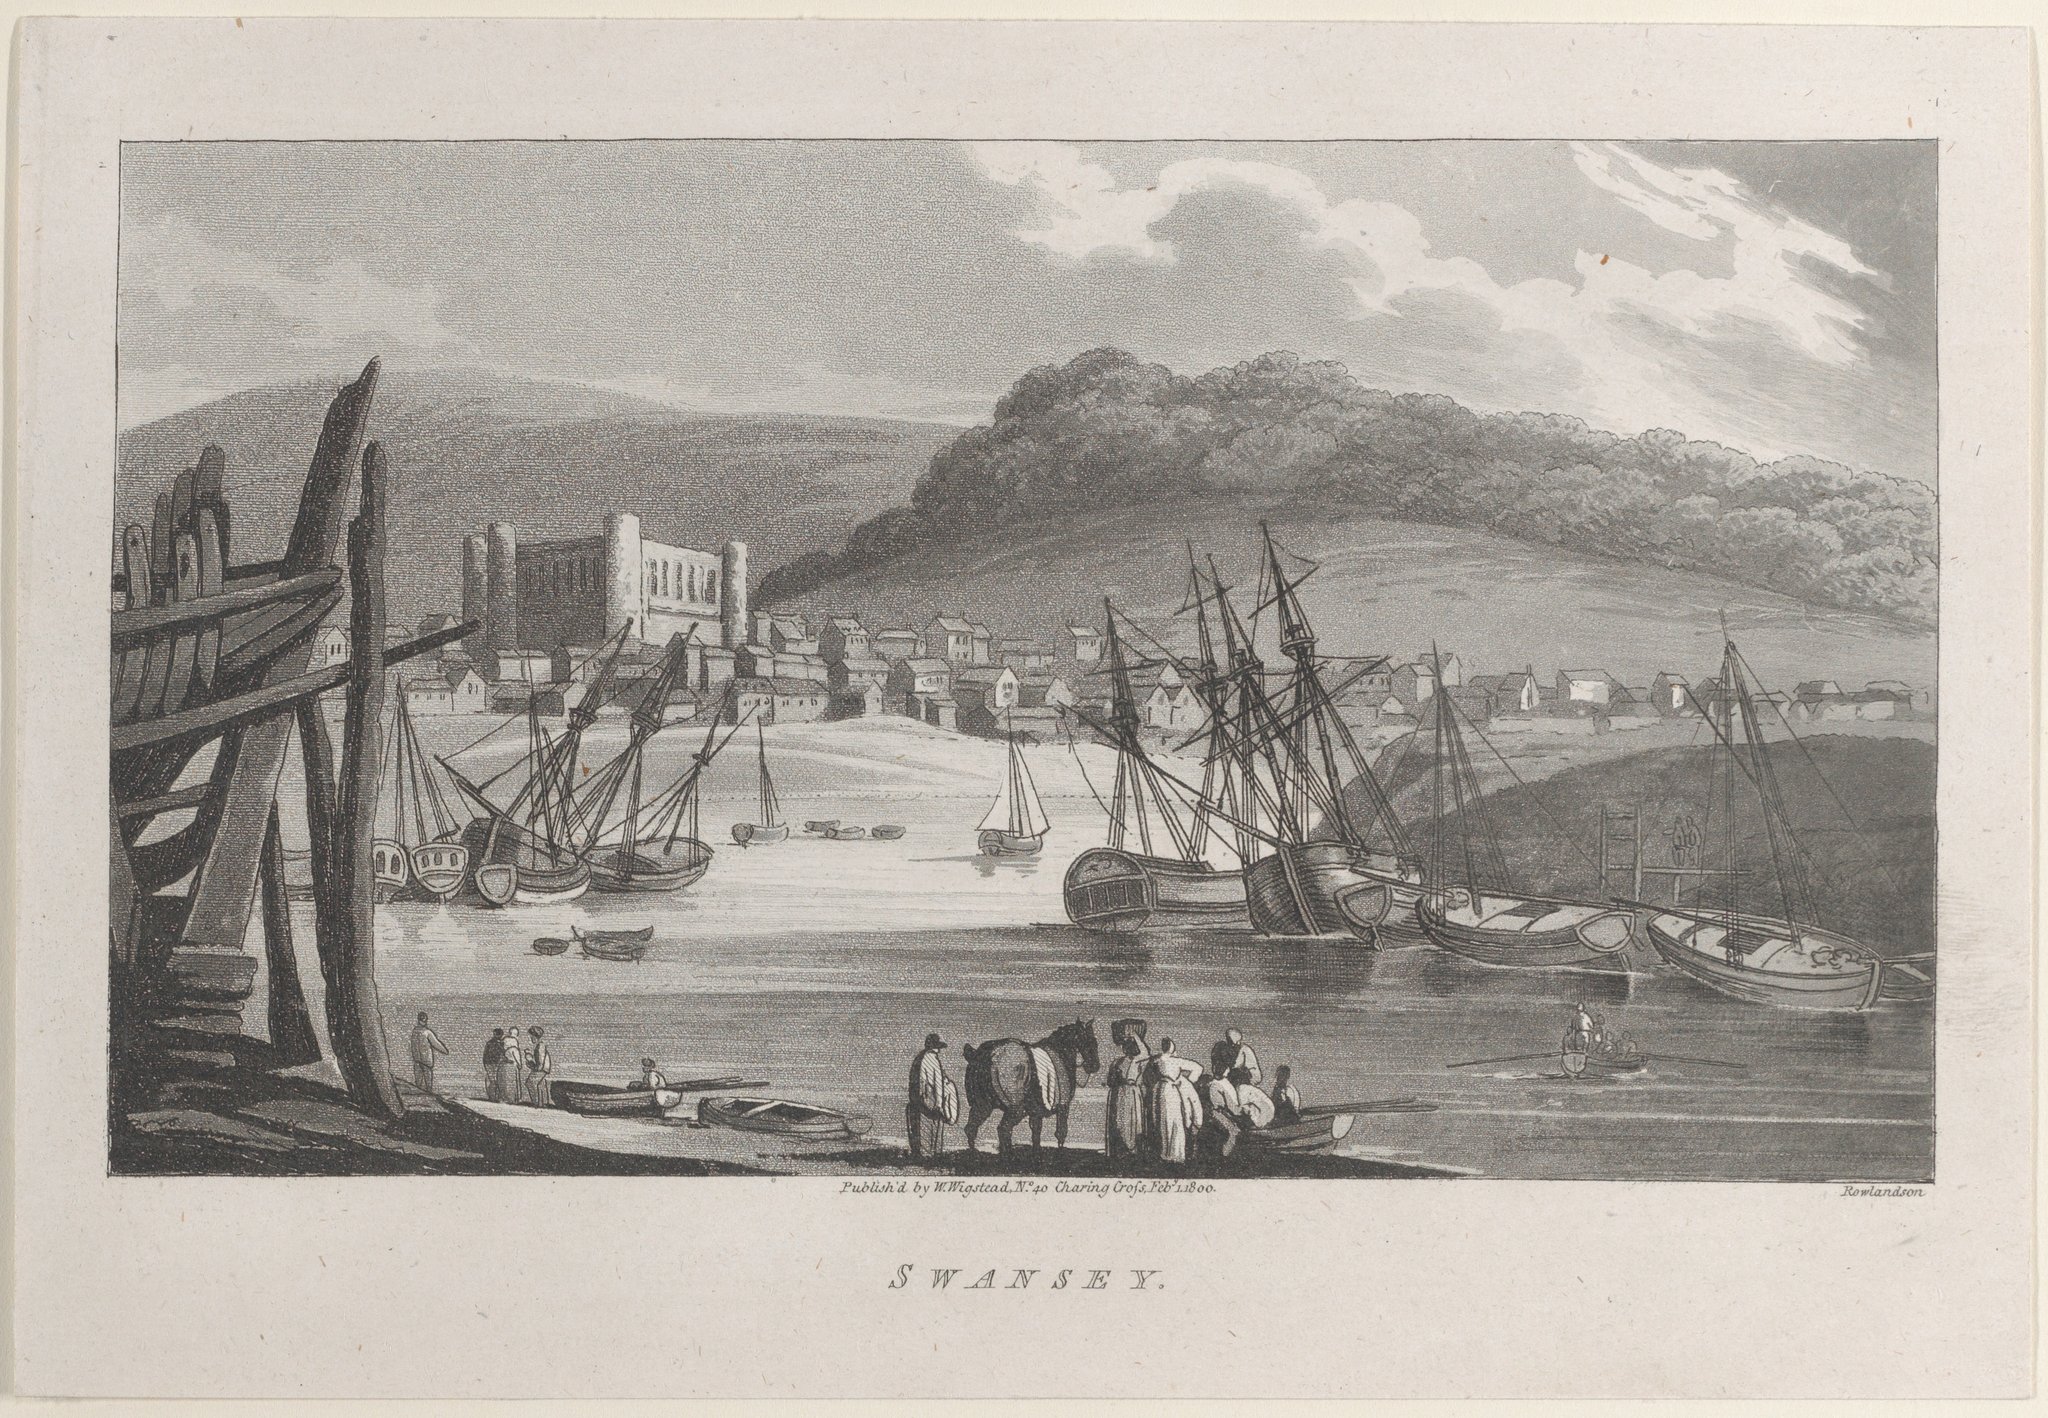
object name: print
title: Swansey, from "Remarks on a Tour to North and South Wales, in the year 1797"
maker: john hill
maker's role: artist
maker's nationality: british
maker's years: 1714-1775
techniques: aquatint, etching